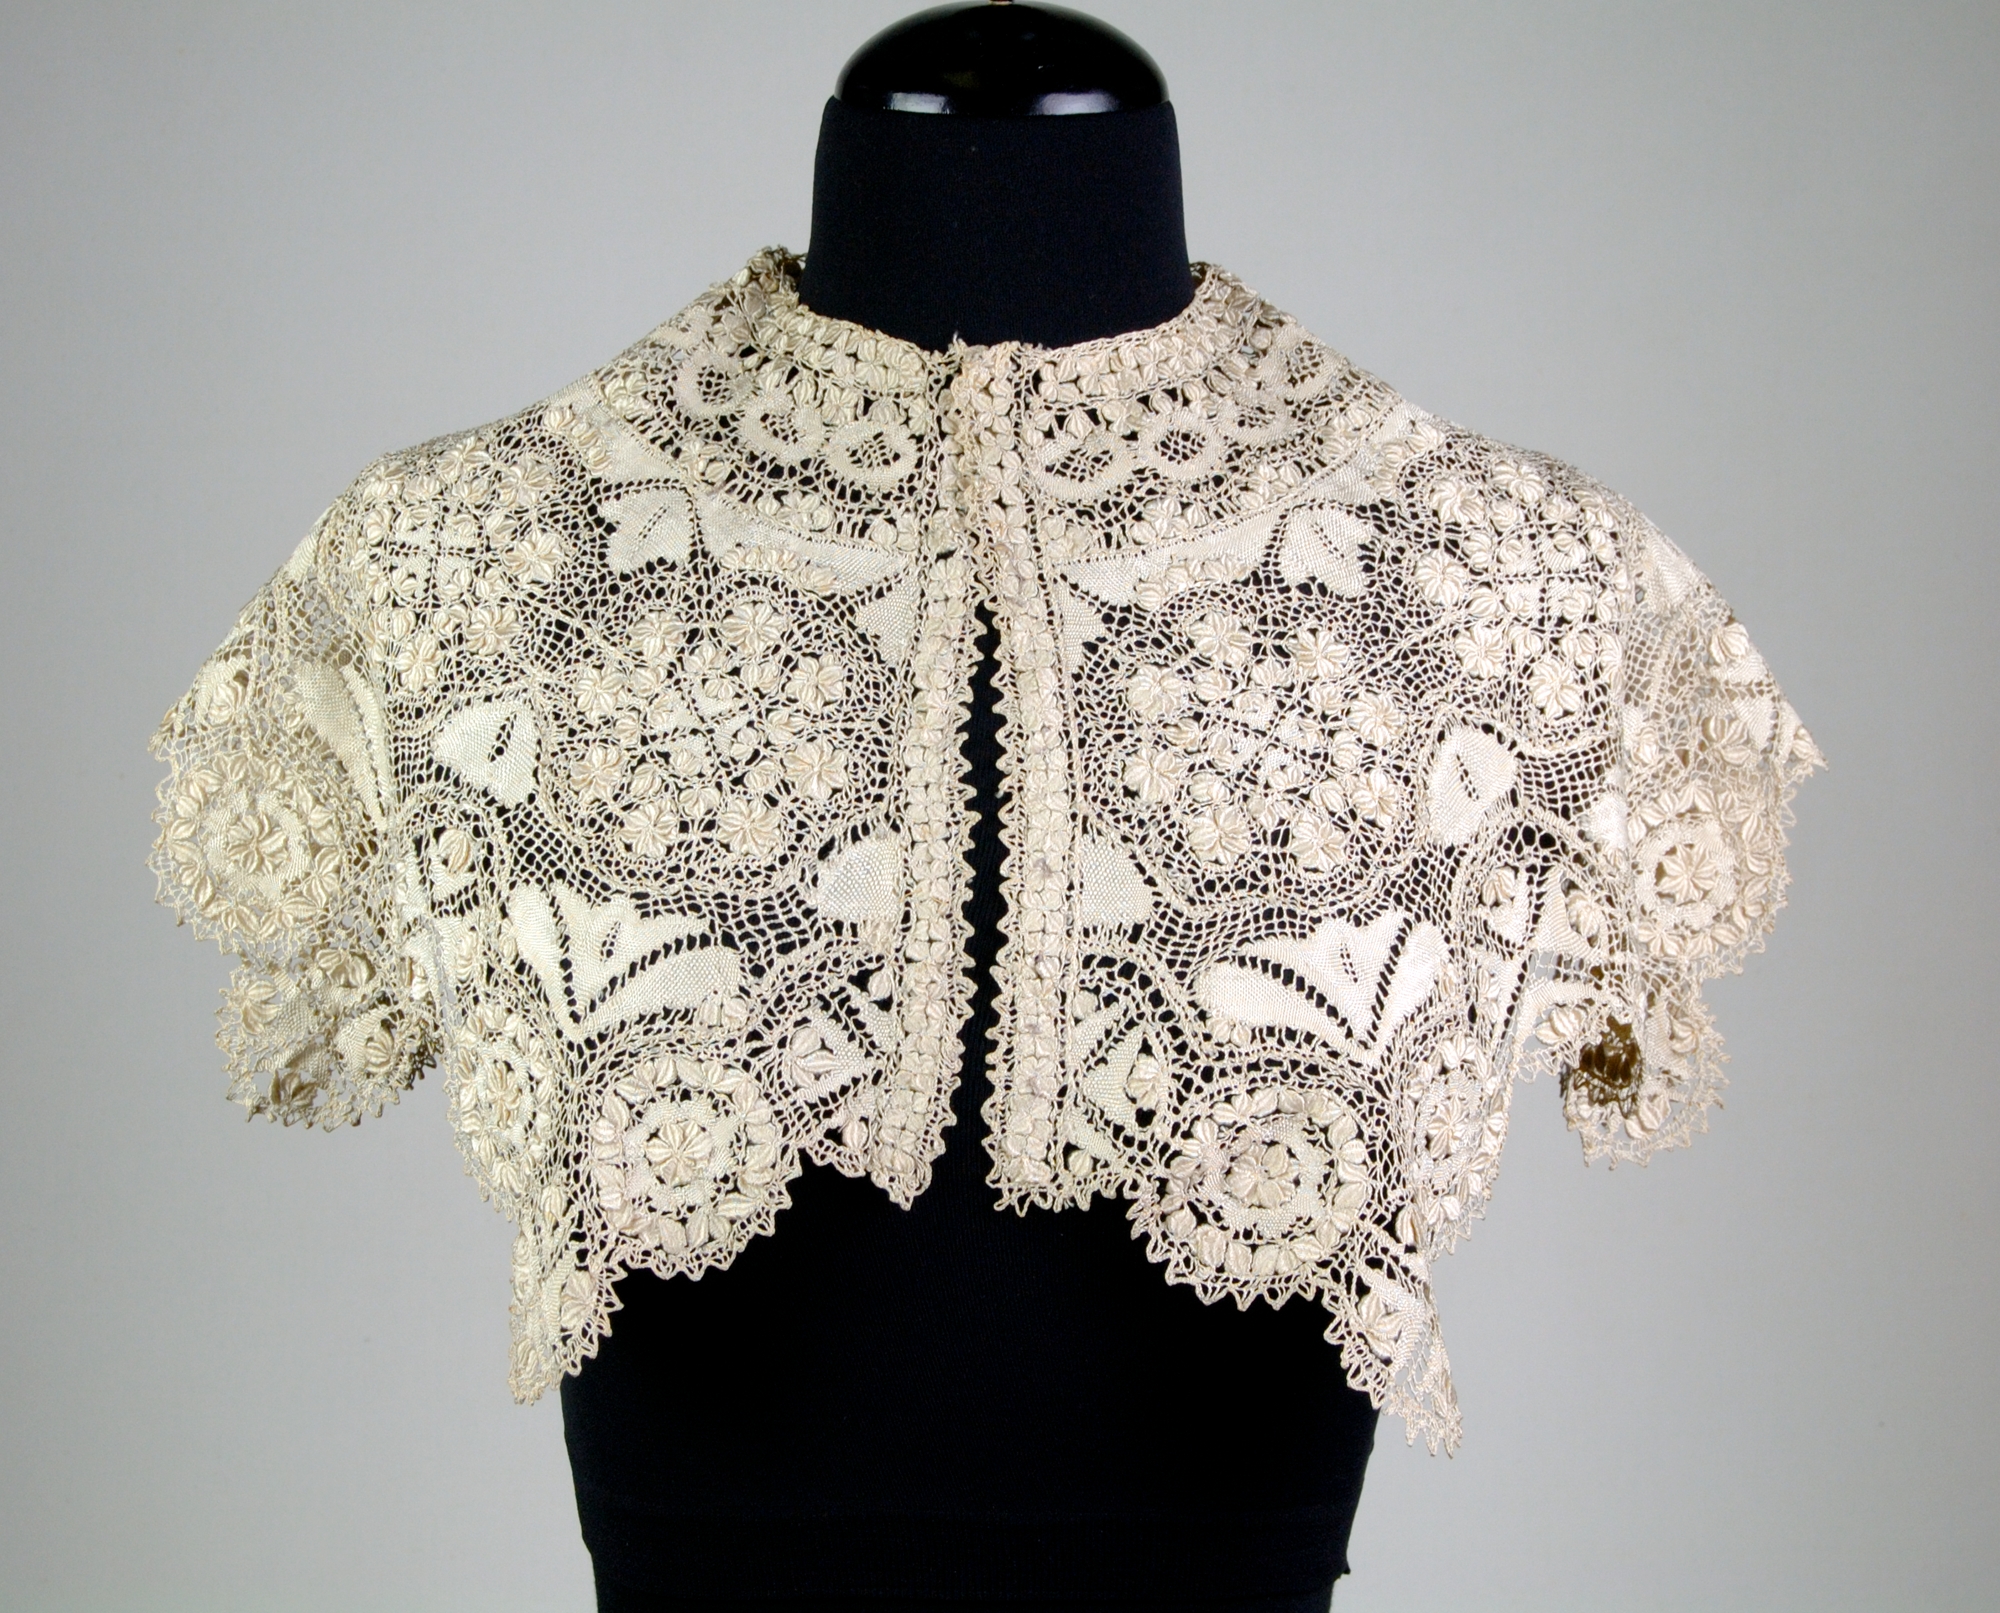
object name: collar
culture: maltese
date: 1895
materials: silk